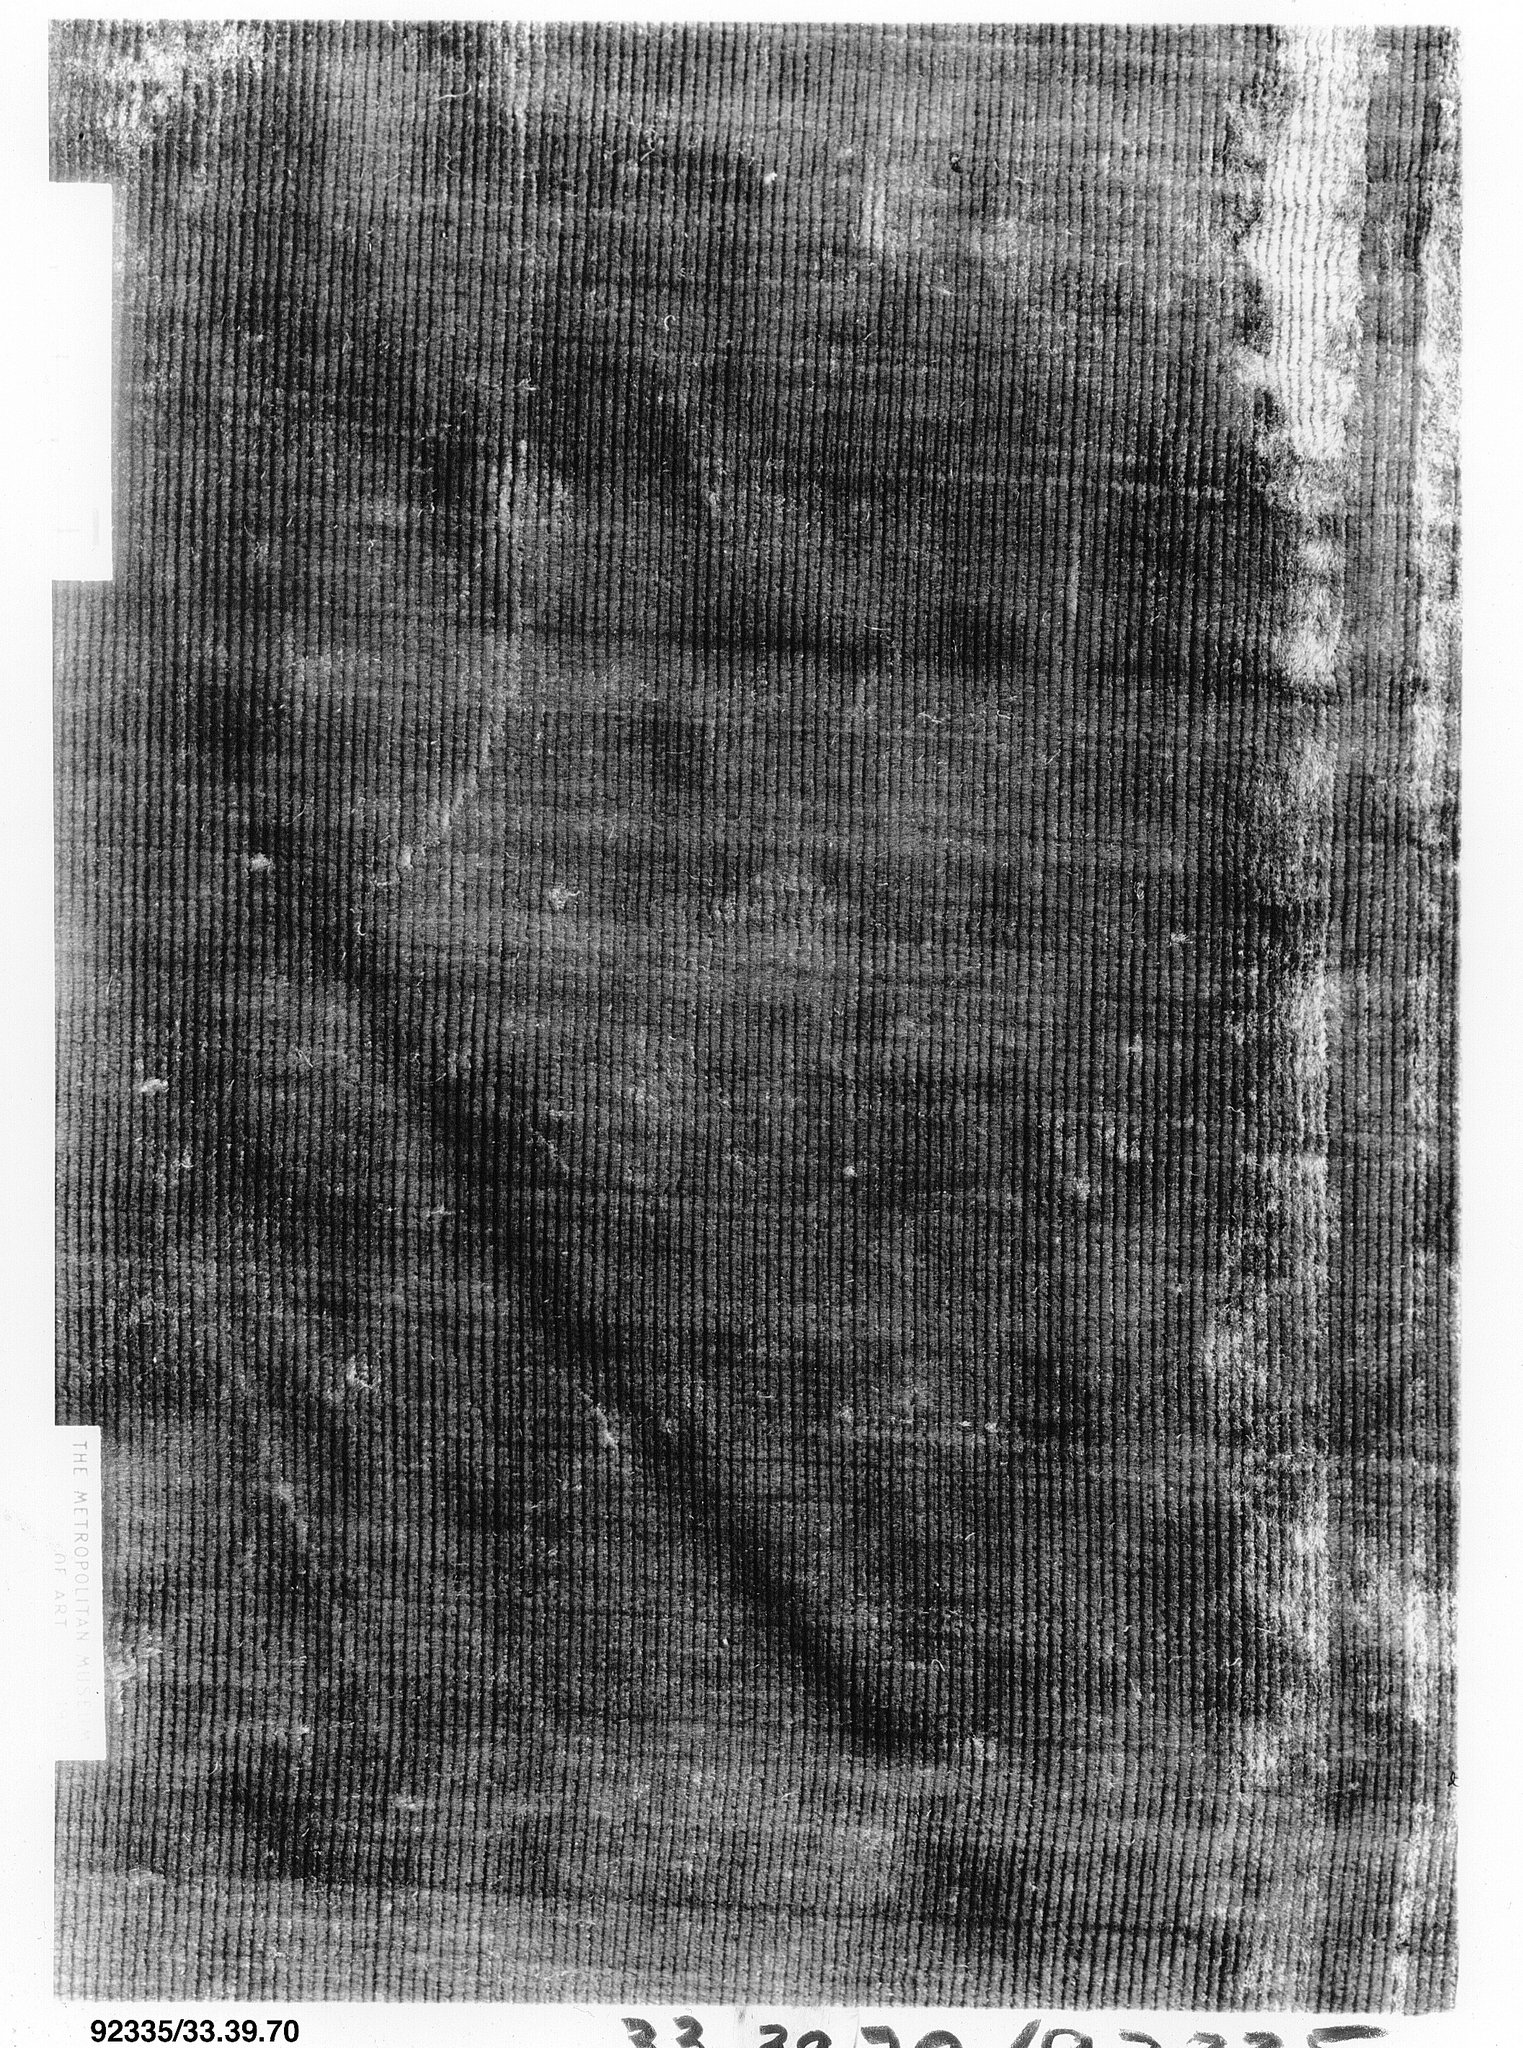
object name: piece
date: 1801-1900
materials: silk